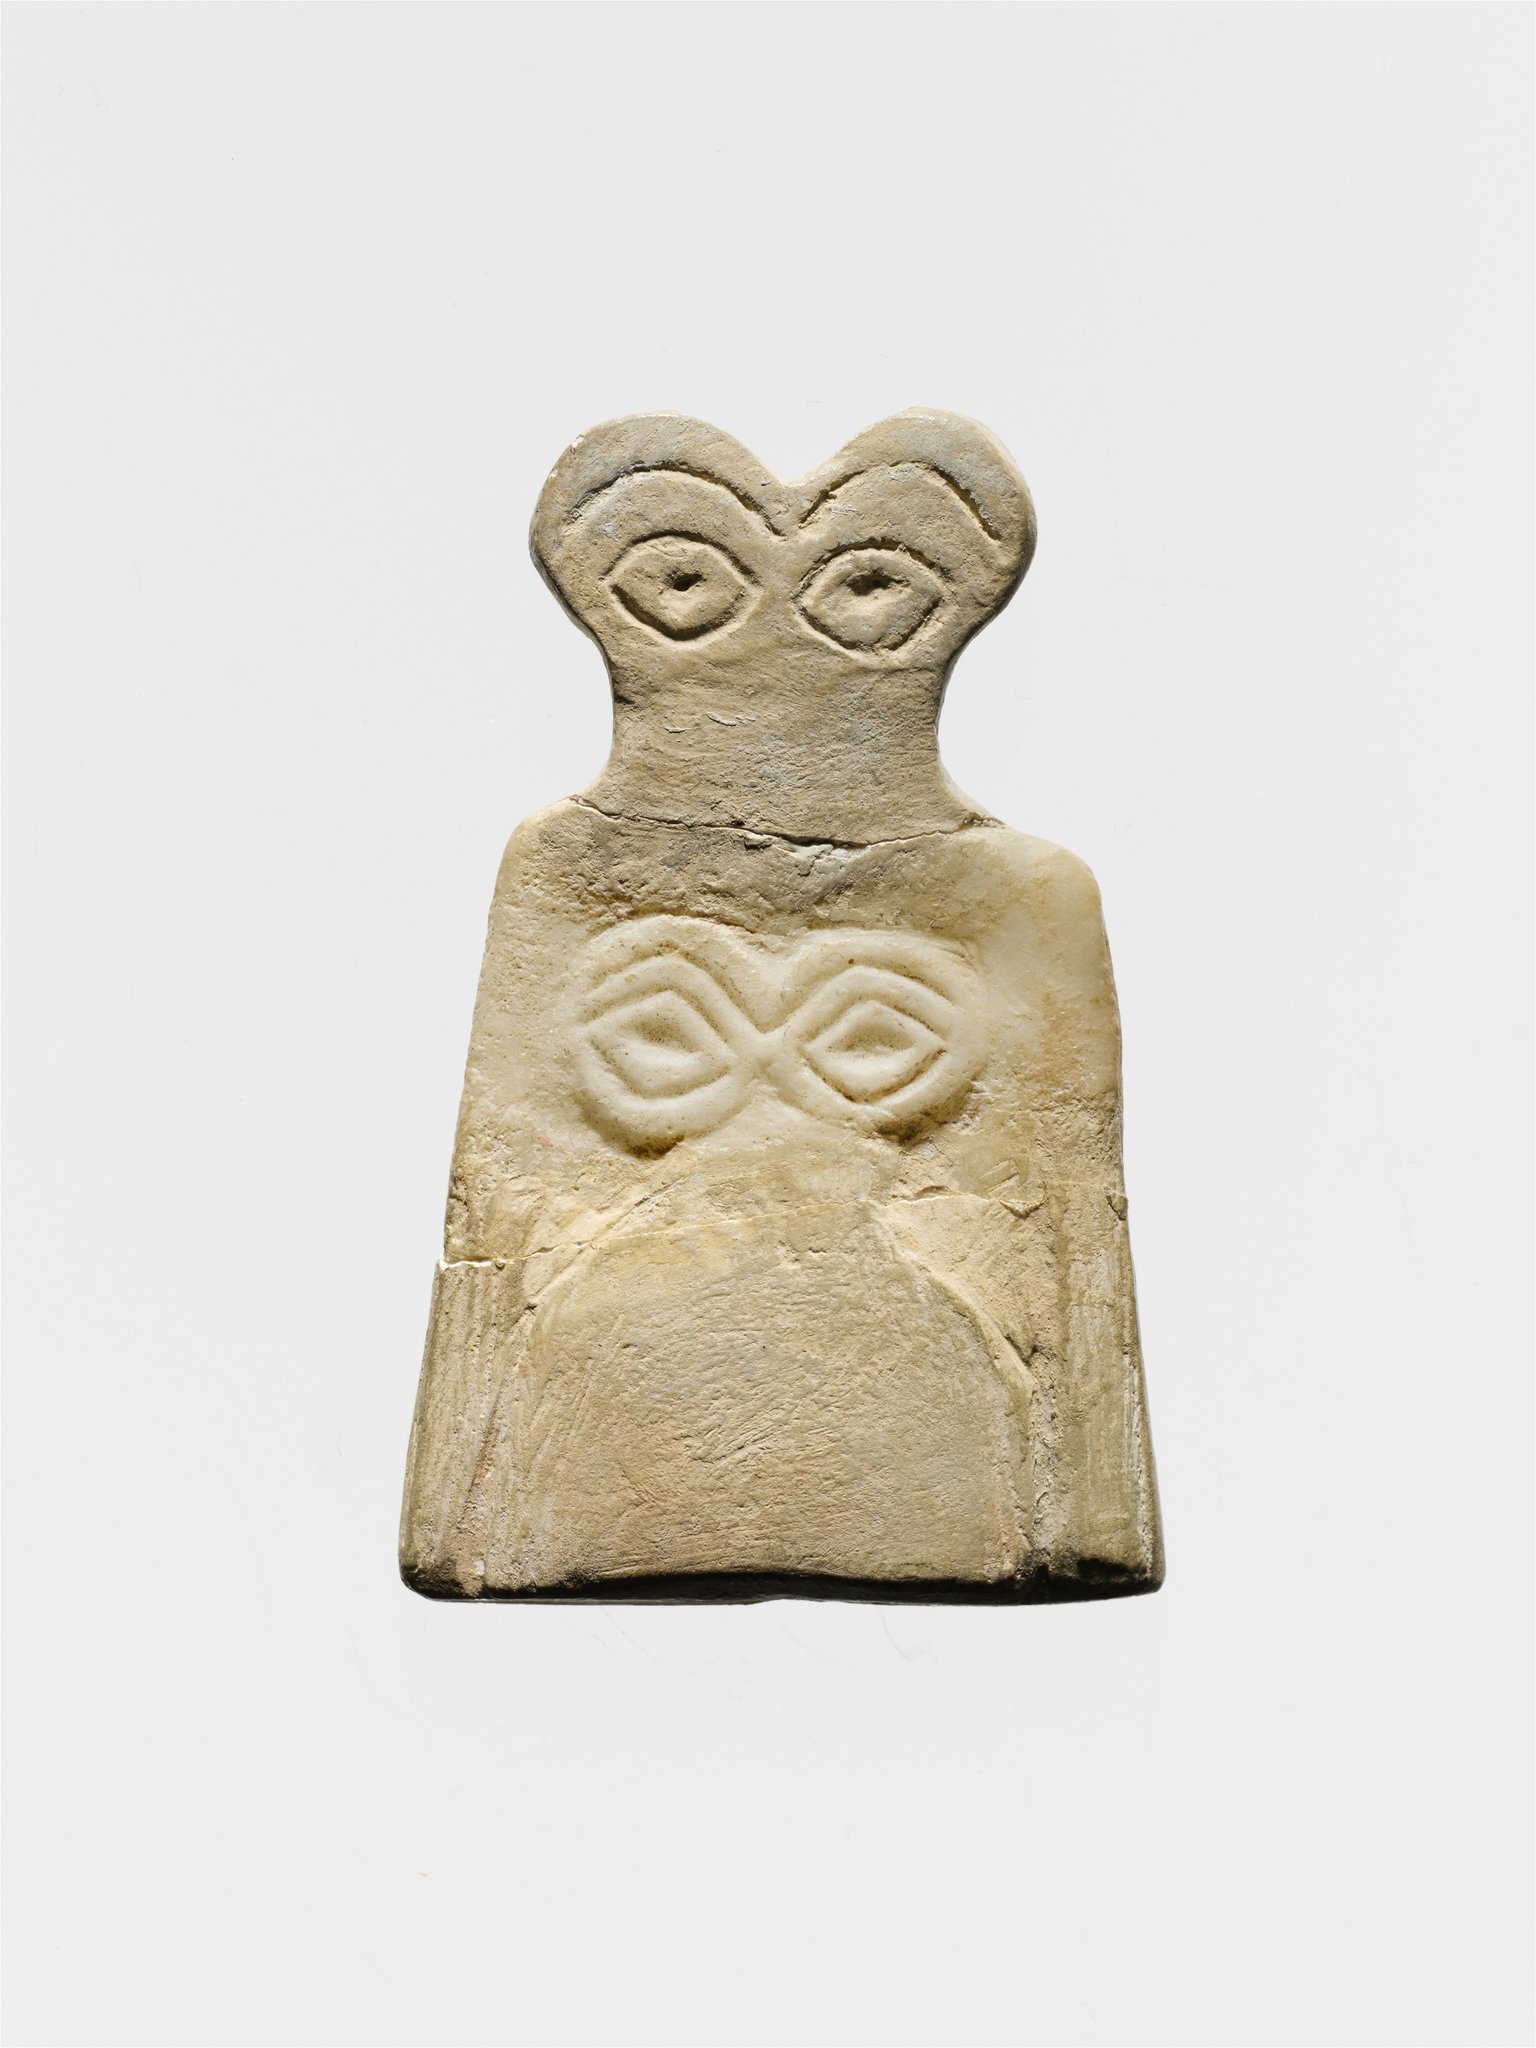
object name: sculpture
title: Eye idol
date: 3700-3500 BCE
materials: alabaster, gypsum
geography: syria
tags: eyes